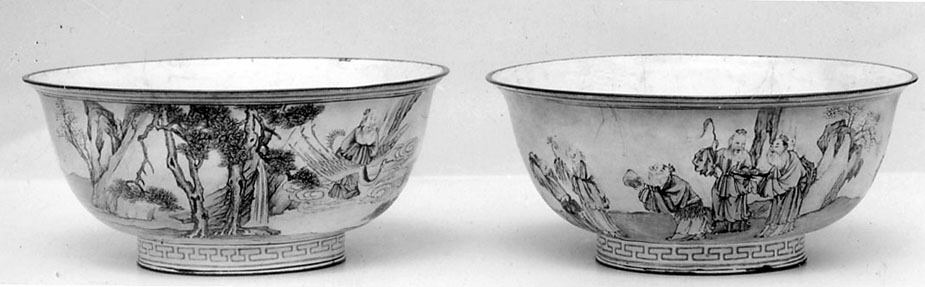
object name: bowl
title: Bowl (one of a pair)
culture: chinese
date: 1801-1833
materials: enamel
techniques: painting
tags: men,trees